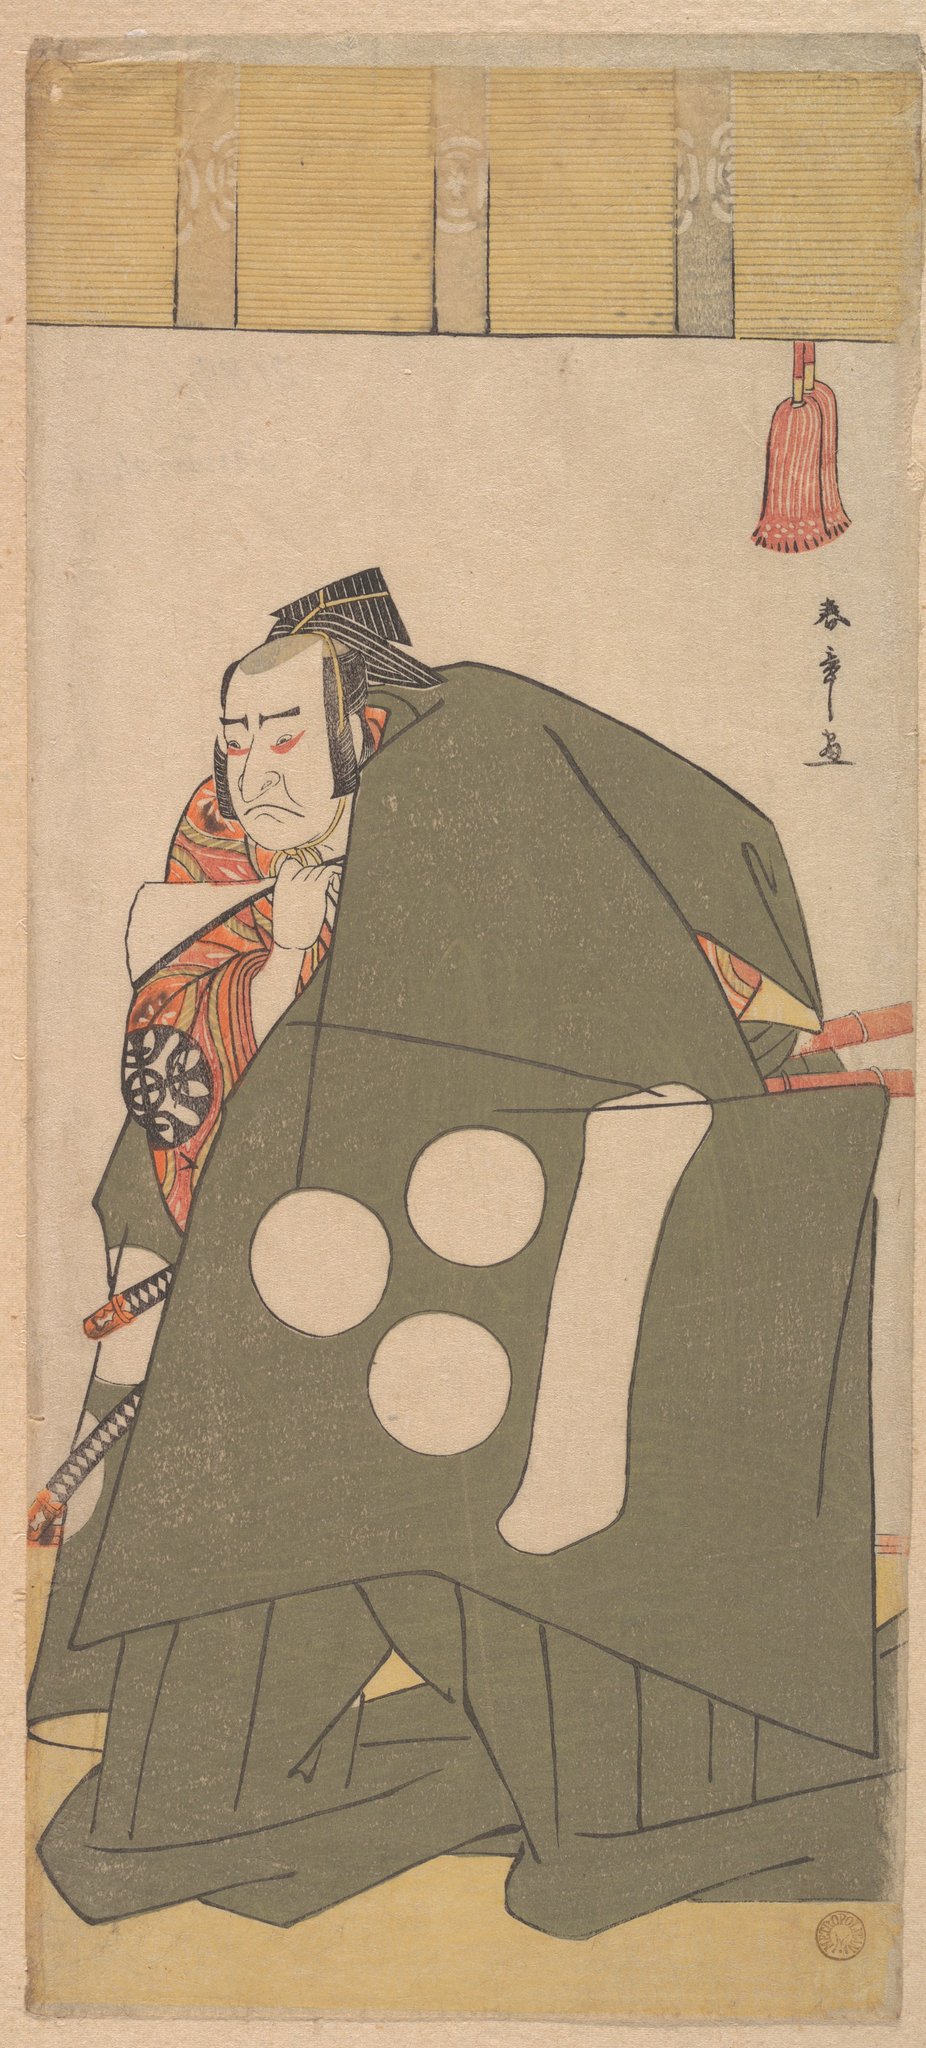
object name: woodblock print nishiki e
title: The Actor Nakamura Nakazo in Shibaraku in Dark Green Robes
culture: japanese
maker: katsukawa shunshō 勝川春章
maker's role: artist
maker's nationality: japanese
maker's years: 1726-1792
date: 1781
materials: ink, paper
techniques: nishiki e, woodblock print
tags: men,actors